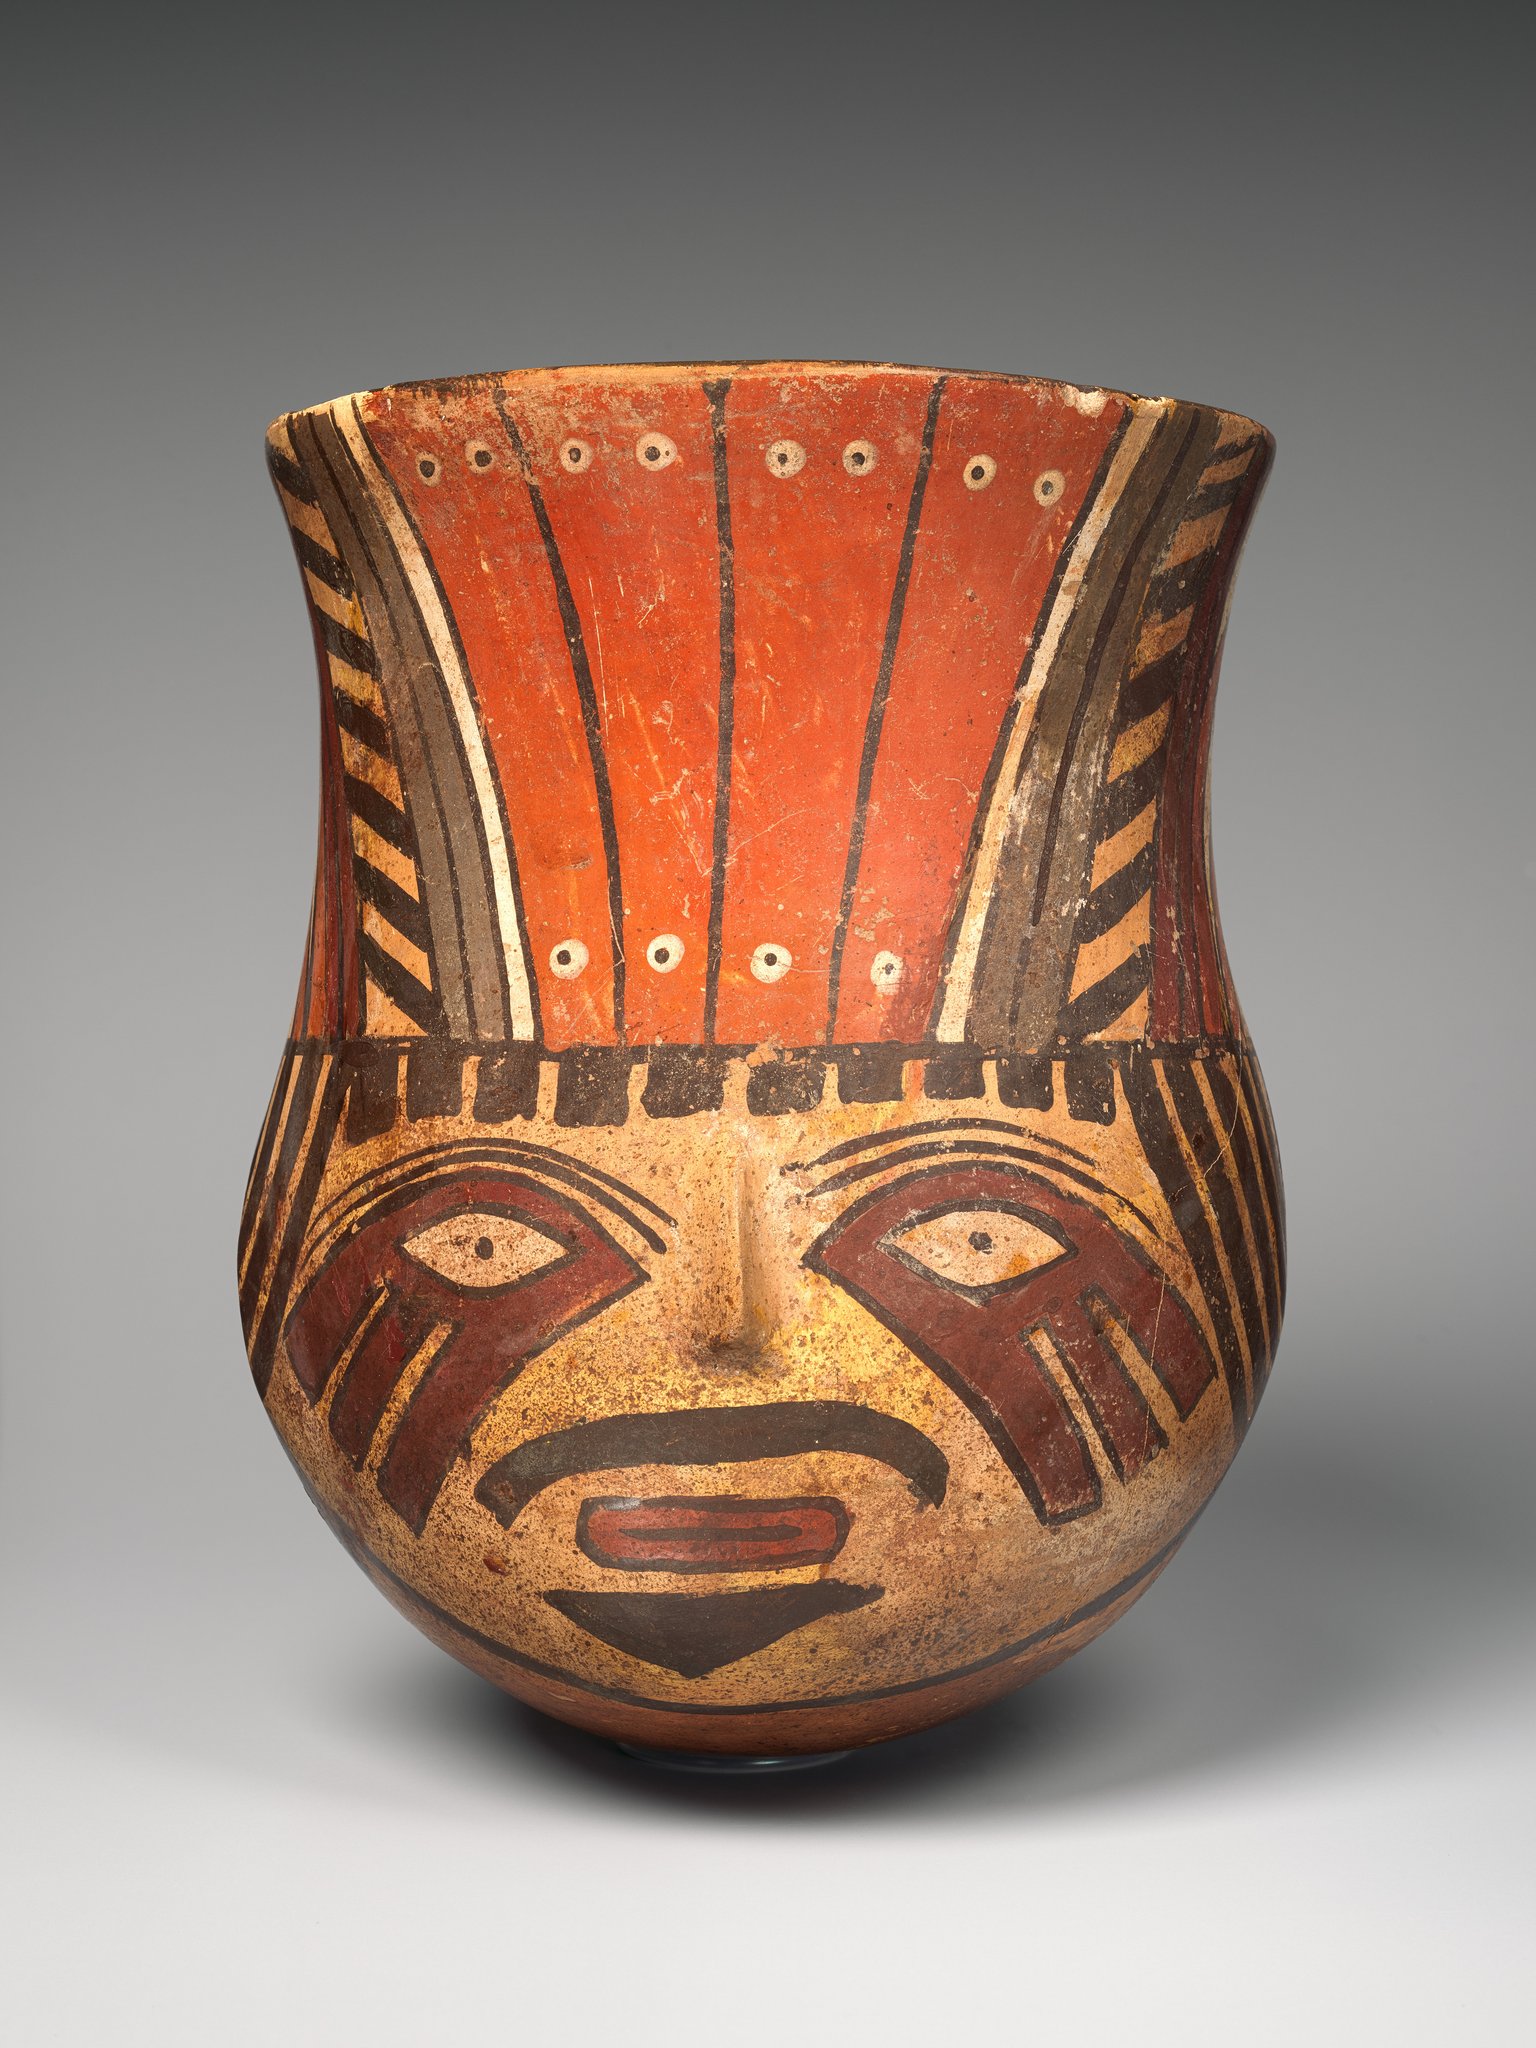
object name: jar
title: Head jar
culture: nasca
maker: nasca artist(s)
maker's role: artist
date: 100-500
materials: ceramic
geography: peru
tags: heads